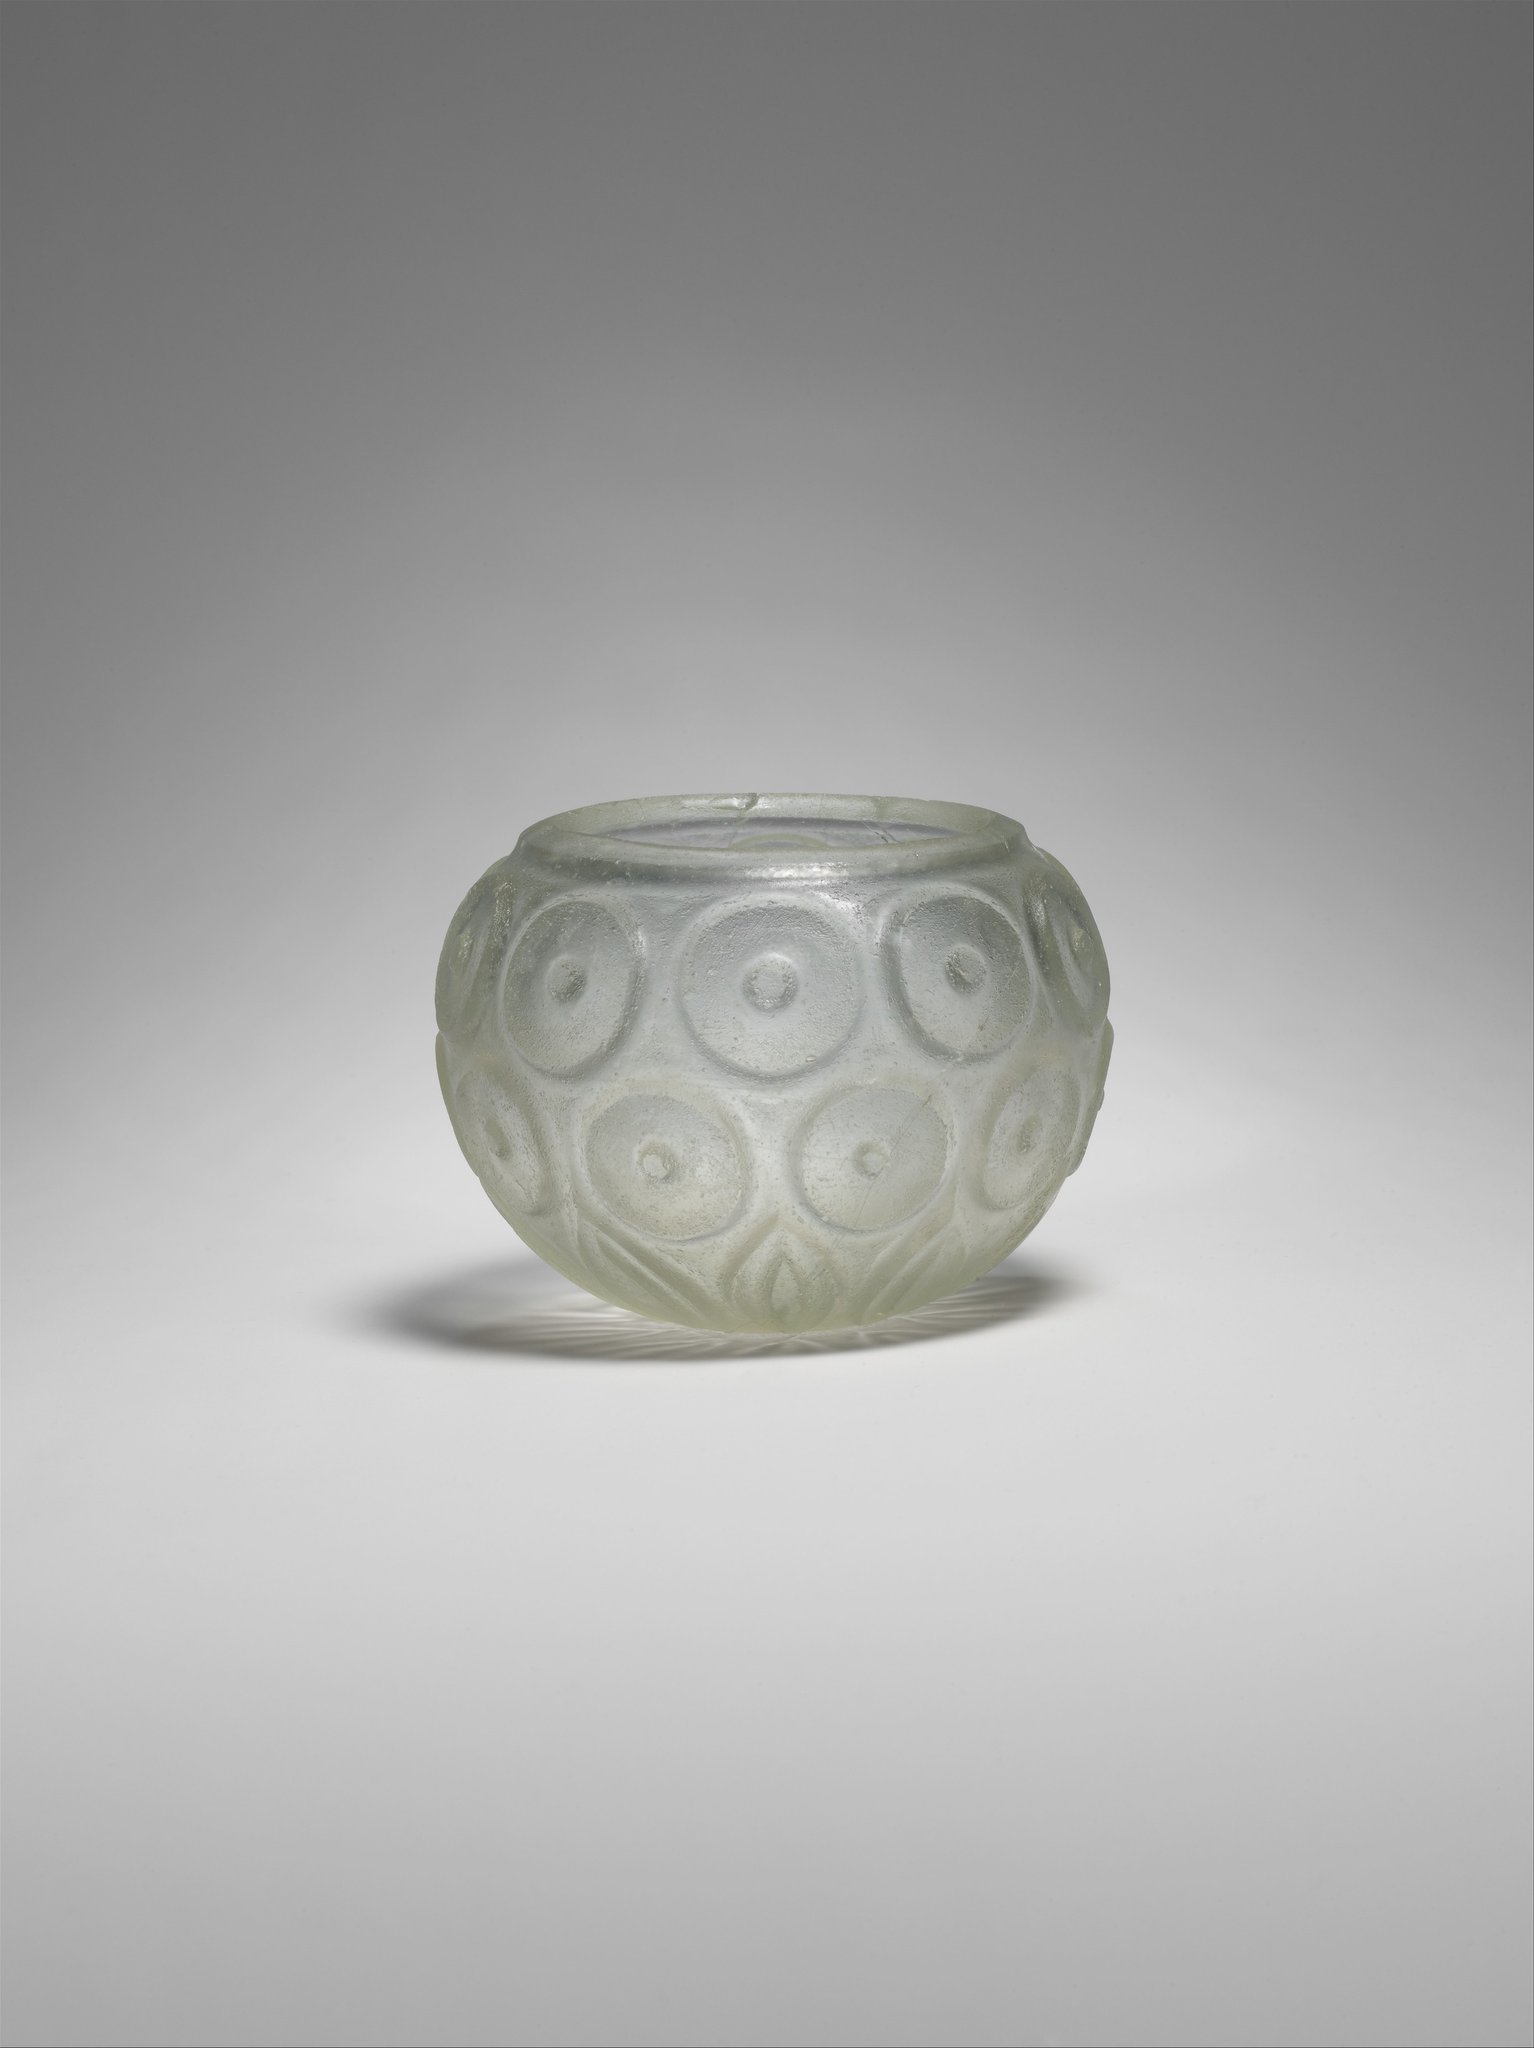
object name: cup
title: Cut-Glass Cup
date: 701-900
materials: glass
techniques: glassblowing, cutting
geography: iran